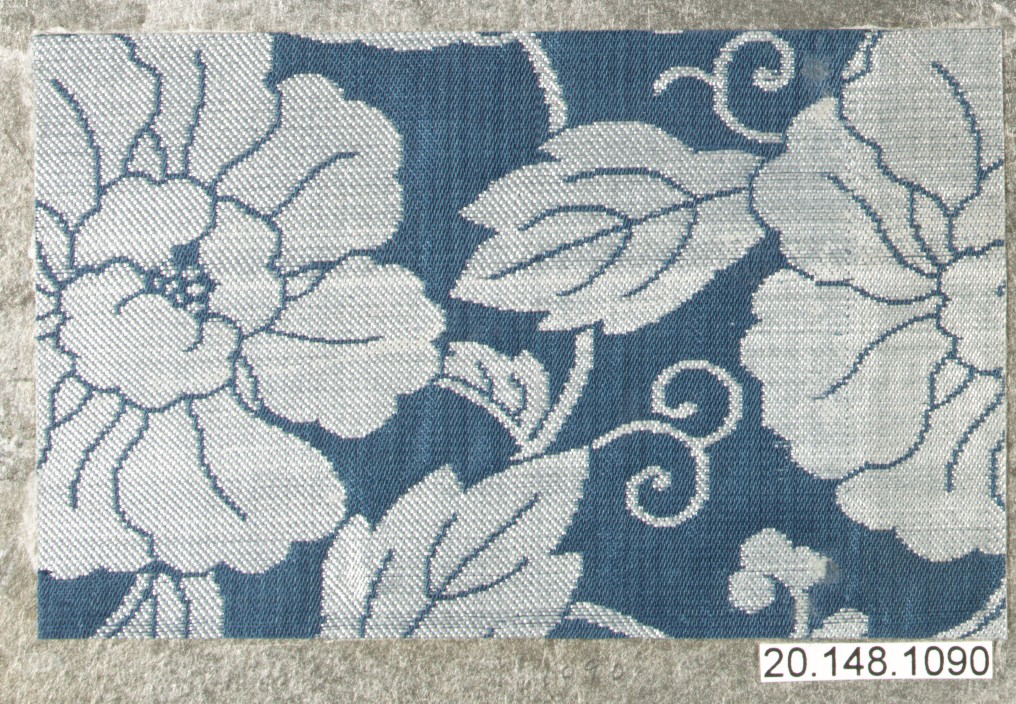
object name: piece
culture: japanese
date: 1801-1900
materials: silk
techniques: compound weave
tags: flowers,leaves